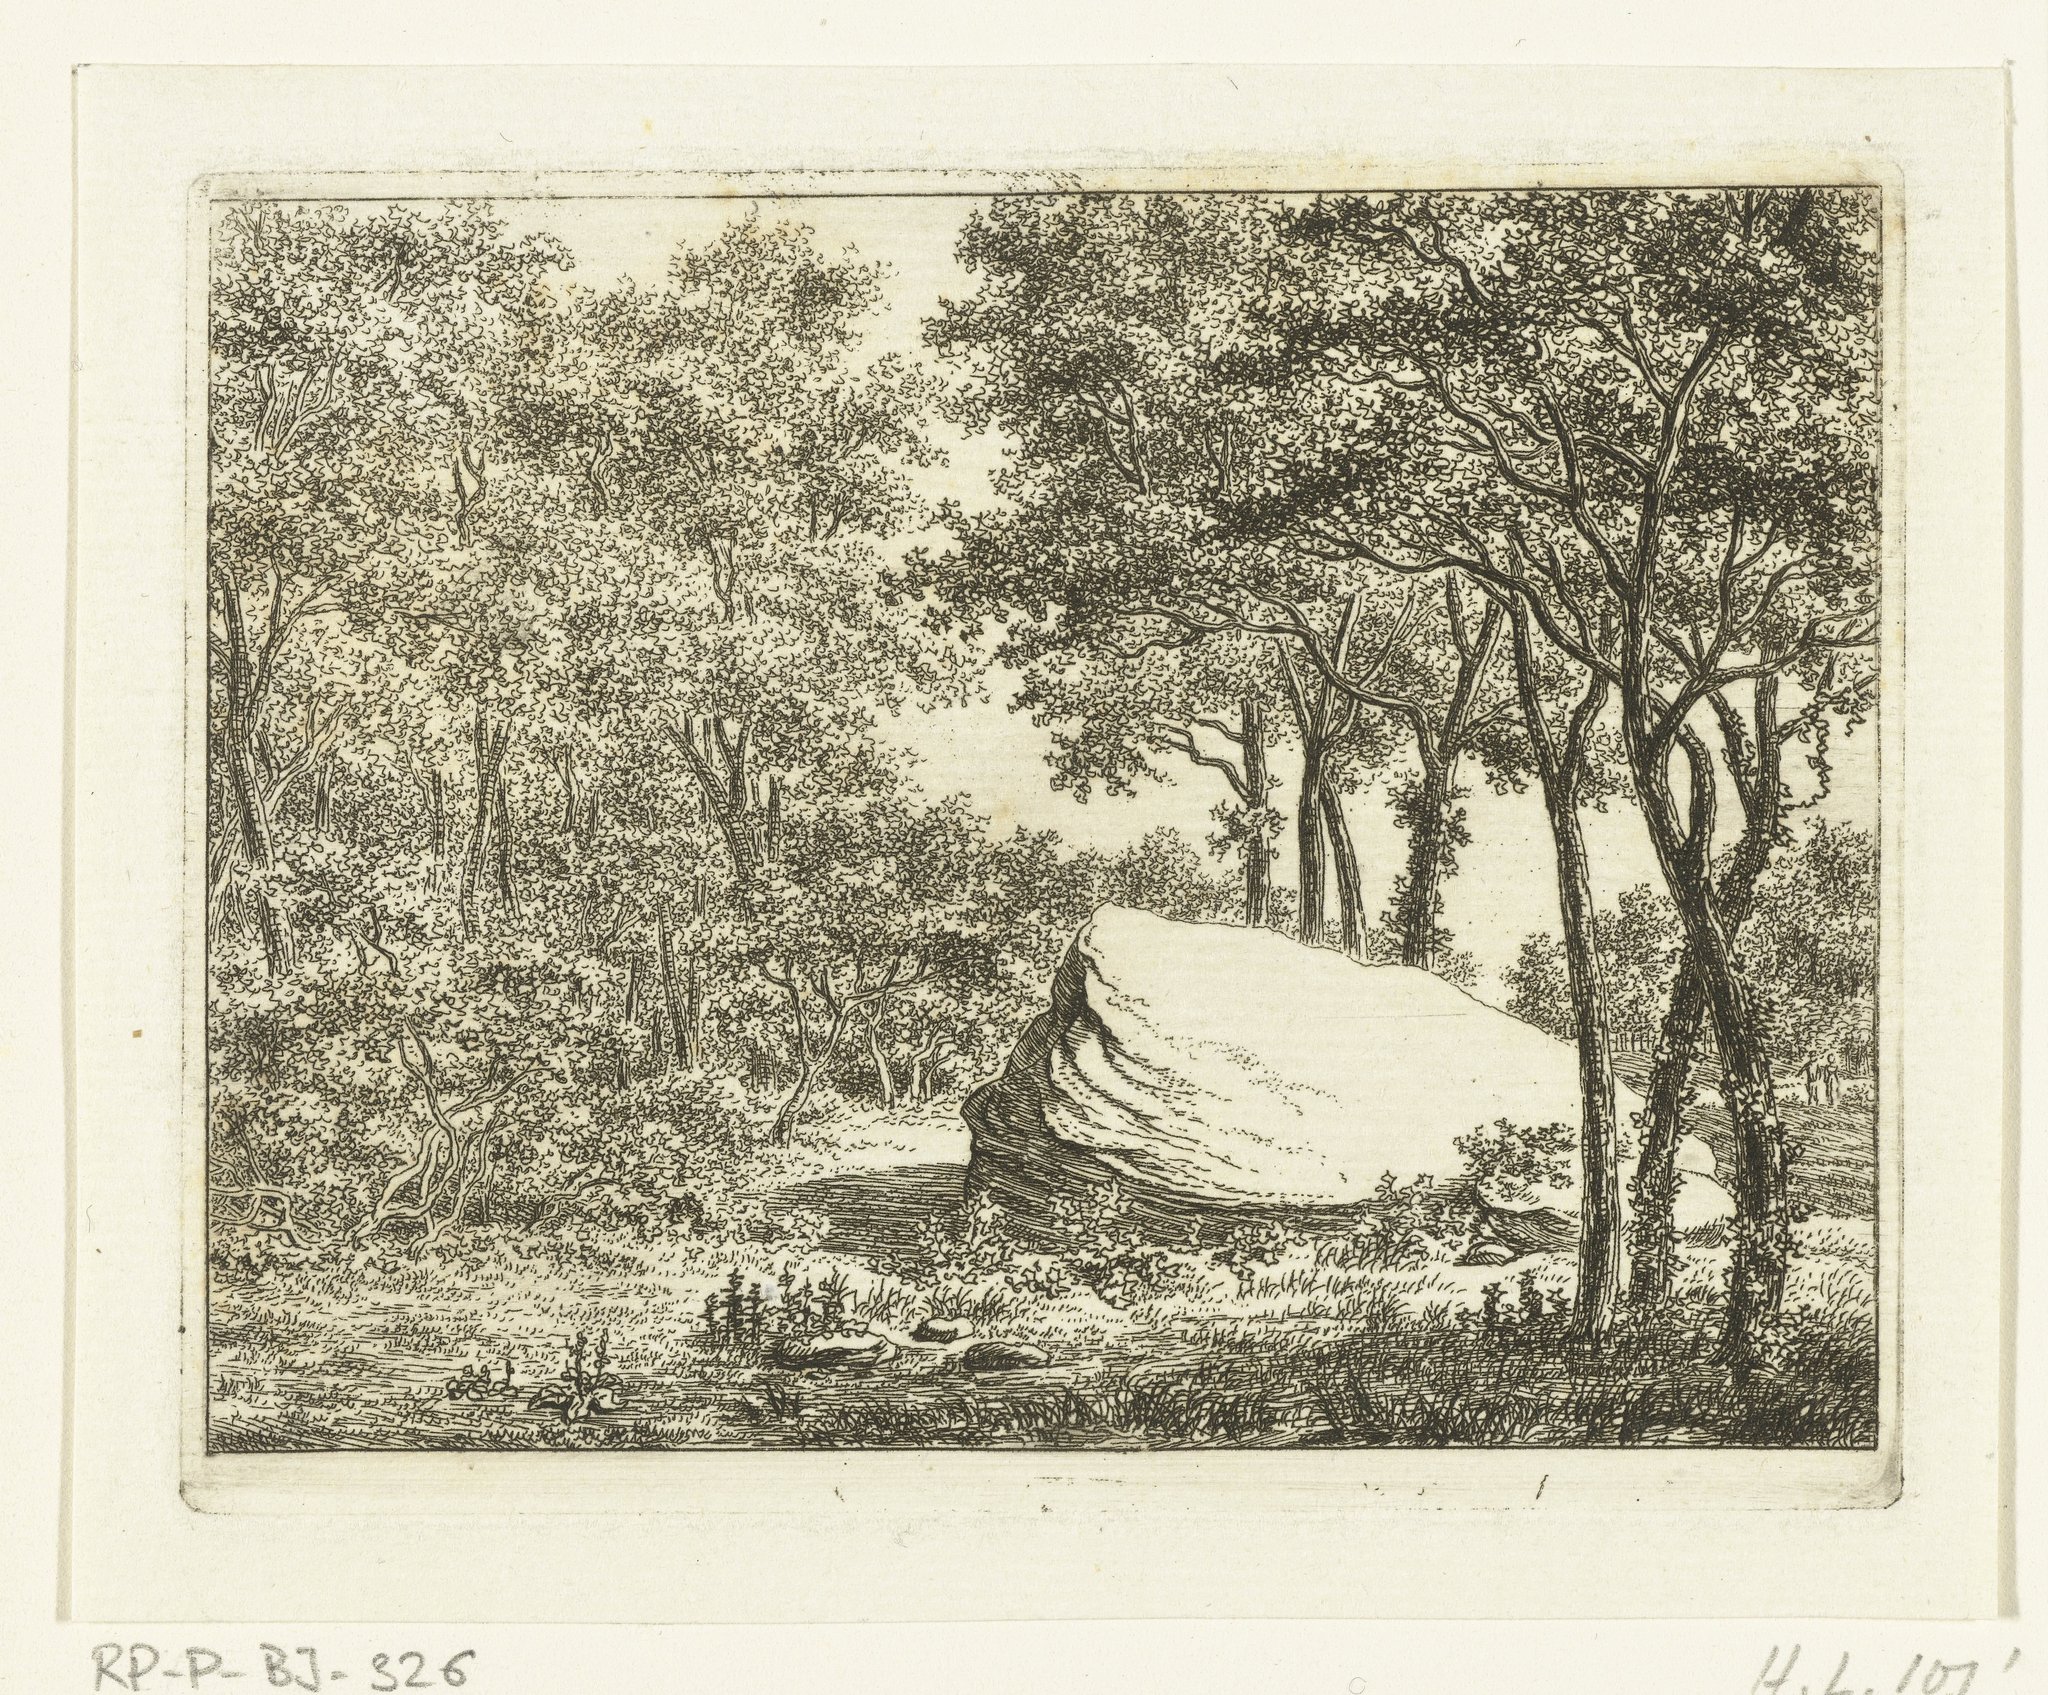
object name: print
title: Landschap met bomen en grote steen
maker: ernst willem jan bagelaar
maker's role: draughtsman, print maker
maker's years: 1775-1837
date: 1798-1819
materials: paper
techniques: etching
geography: netherlands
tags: landscapes in the temperate zone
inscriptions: collector's mark: Lugt 2228